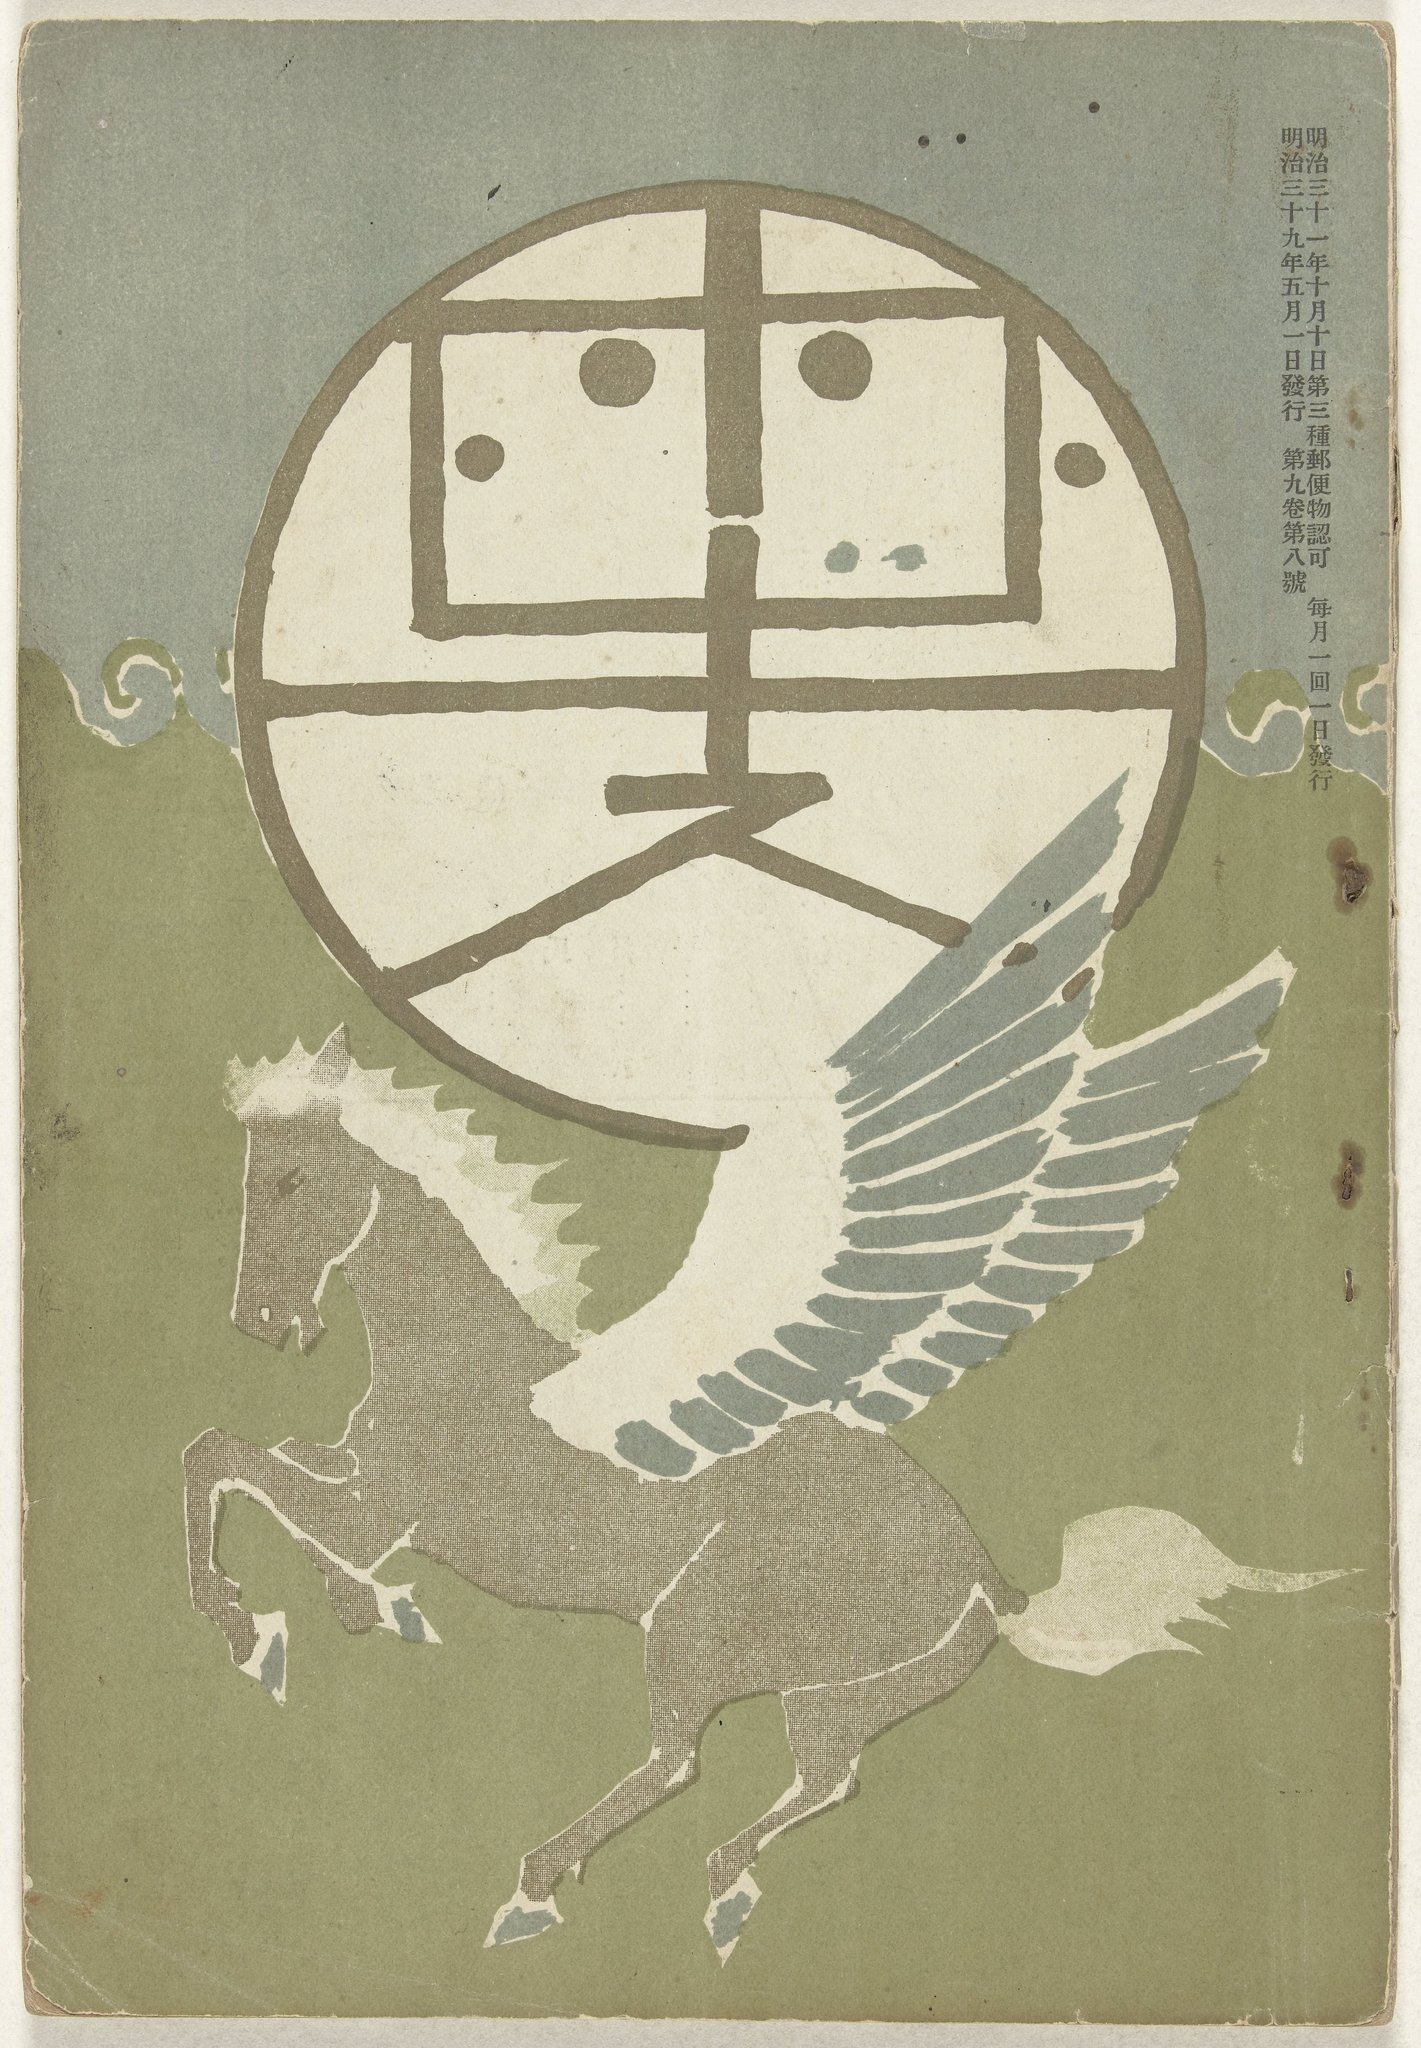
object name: magazine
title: Hototogisu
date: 1906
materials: paper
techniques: woodcut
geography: japan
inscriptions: date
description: Nummer 8 van jaargang 9 (mei 1906)van het literaire maandblad Hototogisu: kaft met afbeelding van gevleugeld paard tegen groene achtergrond met grijsgroene lucht; achterkant, afbeelding van visser in bootje.